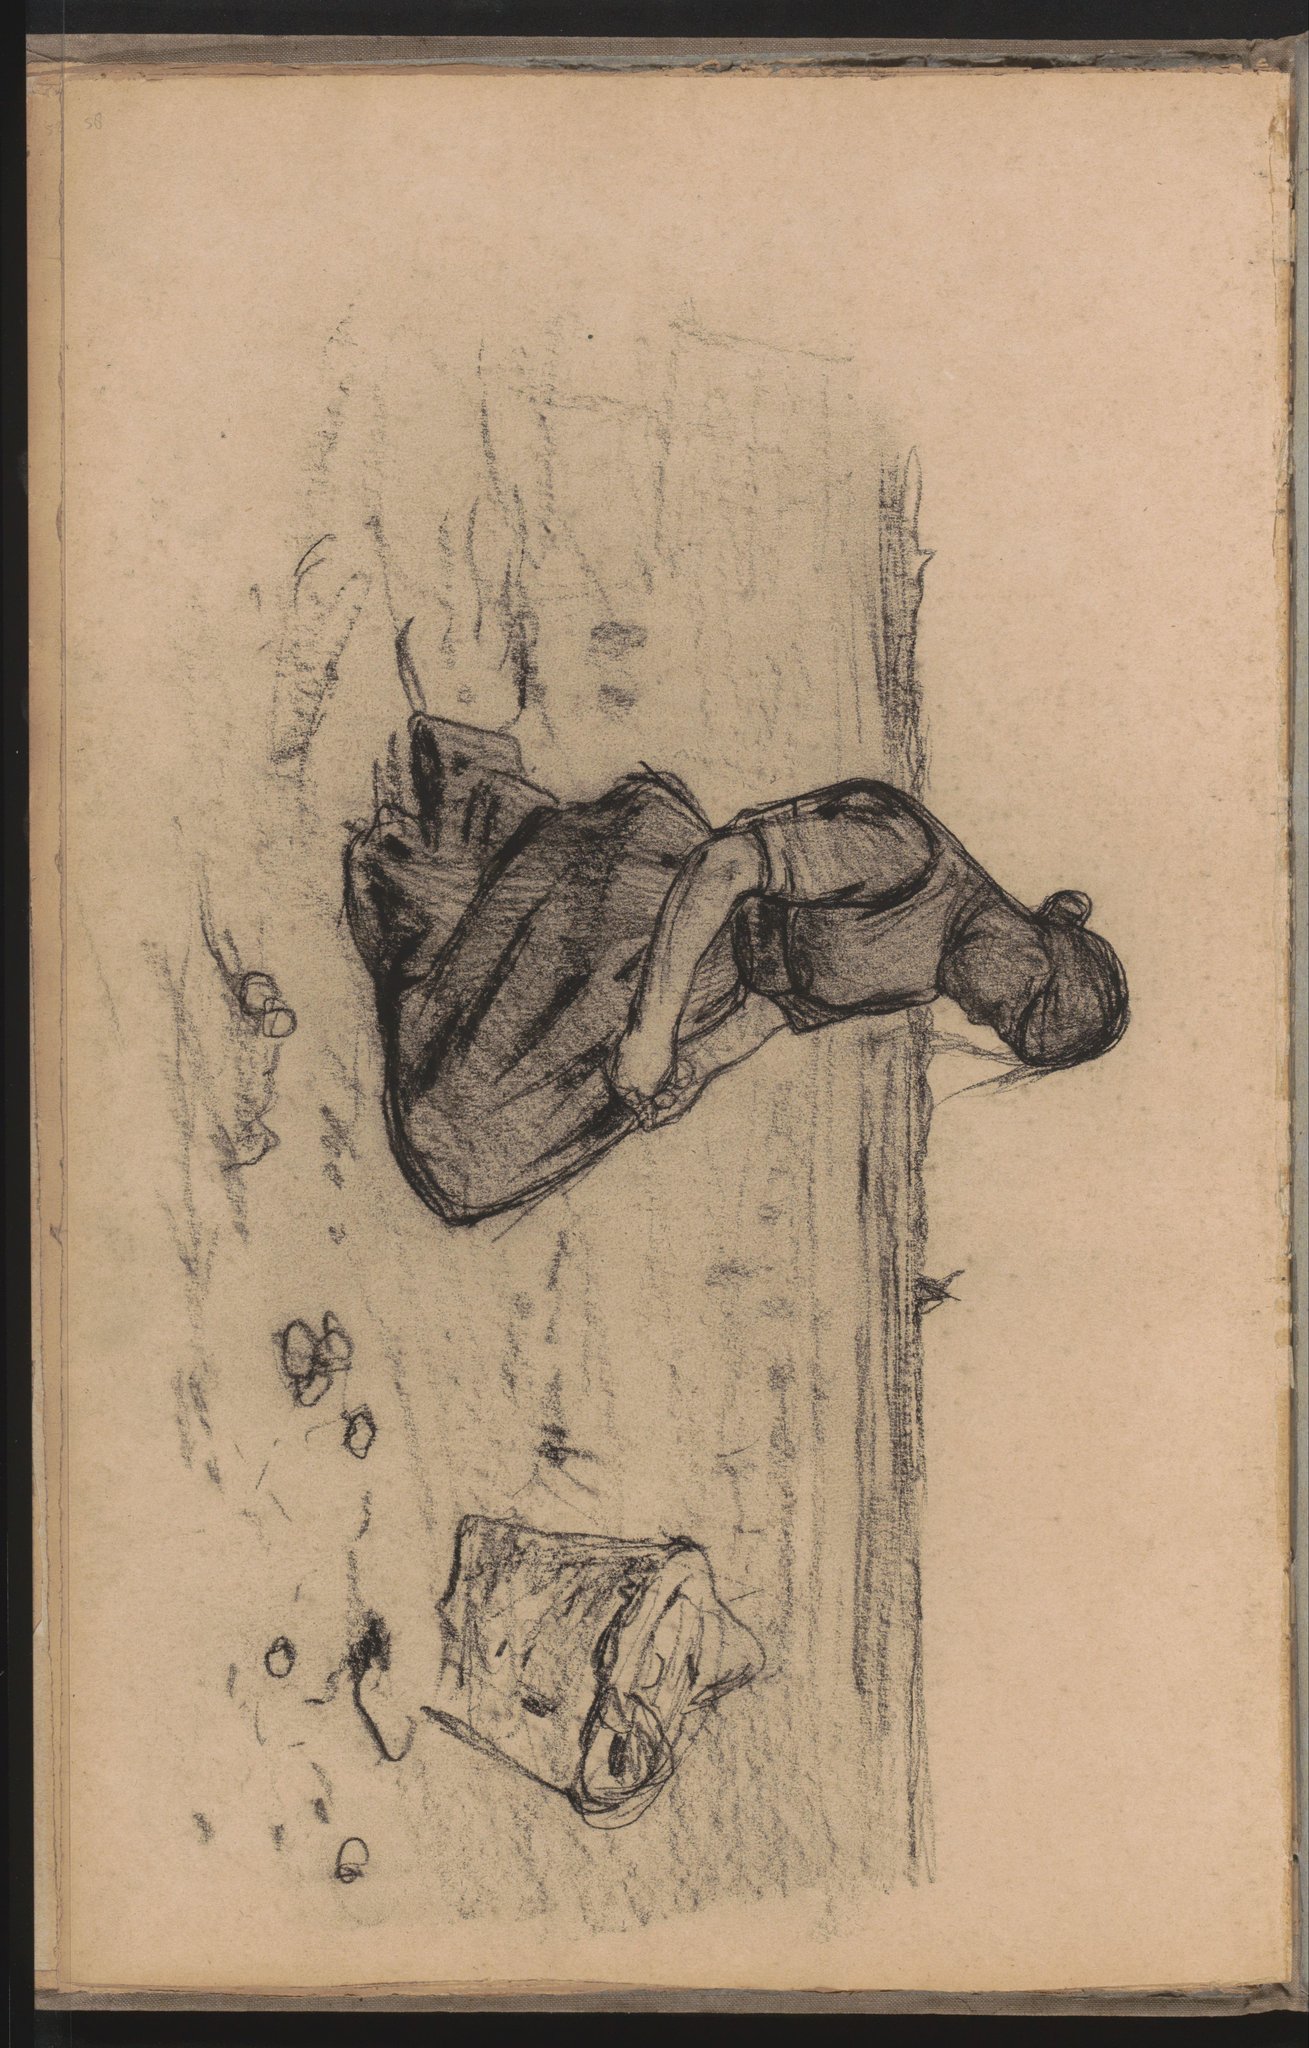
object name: sketchbook leaf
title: Aardappelrooister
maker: willem witsen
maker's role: draughtsman, painter, print maker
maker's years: 1860-1923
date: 1886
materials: chalk, paper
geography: ewijkshoeve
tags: adolescent, young woman, maiden (+ kneeling), potatoes, reaping, picking, mowing ~ harvest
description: Een jonge vrouw knielt bij een mand. In de verte bebouwing. Pagina 58 uit een schetsboek met 38 bladen betekend rond de Ewijkshoeve.